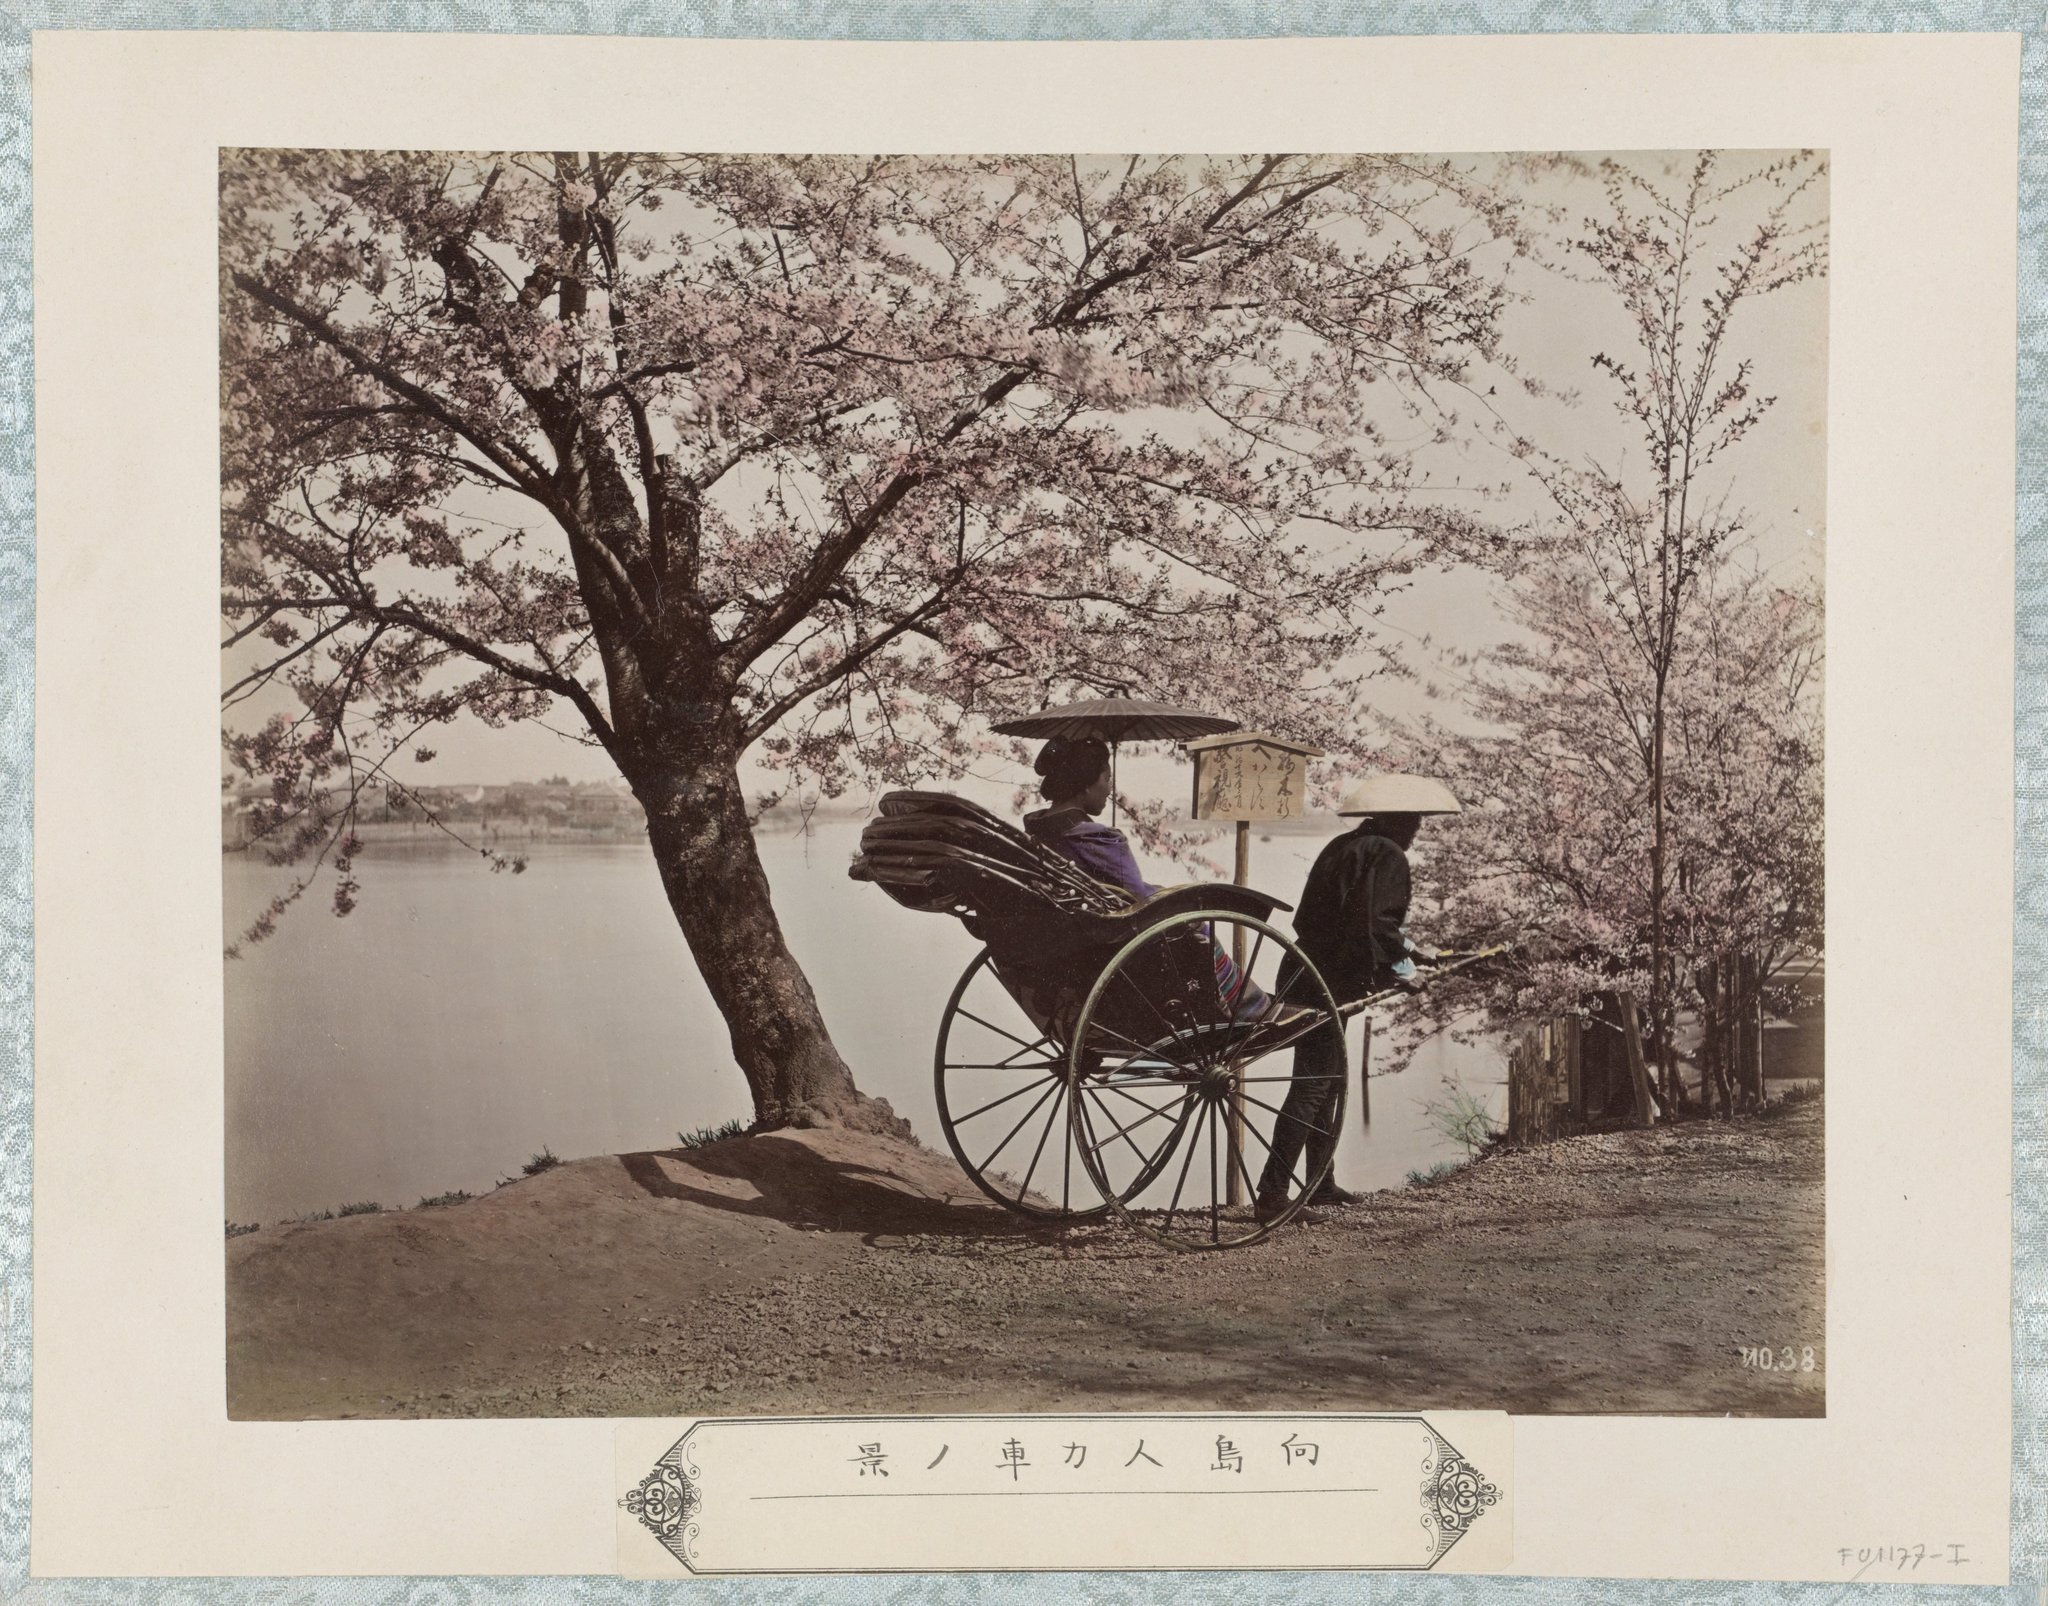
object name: photograph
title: Gezicht op Mukaijima met riksha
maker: Anonymous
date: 1870-1900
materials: cardboard, paper, photographic support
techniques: albumen print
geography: kyoto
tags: rickshaw, river, river bank, head-gear: hat, travelling; tourism, parasol, sunshade, trees (+ flowers, blossom, blossoming), kyoto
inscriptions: inscription: ‘38’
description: Onderdeel van Leporelloalbum met 30 foto's van bezienswaardigheden in Japan.